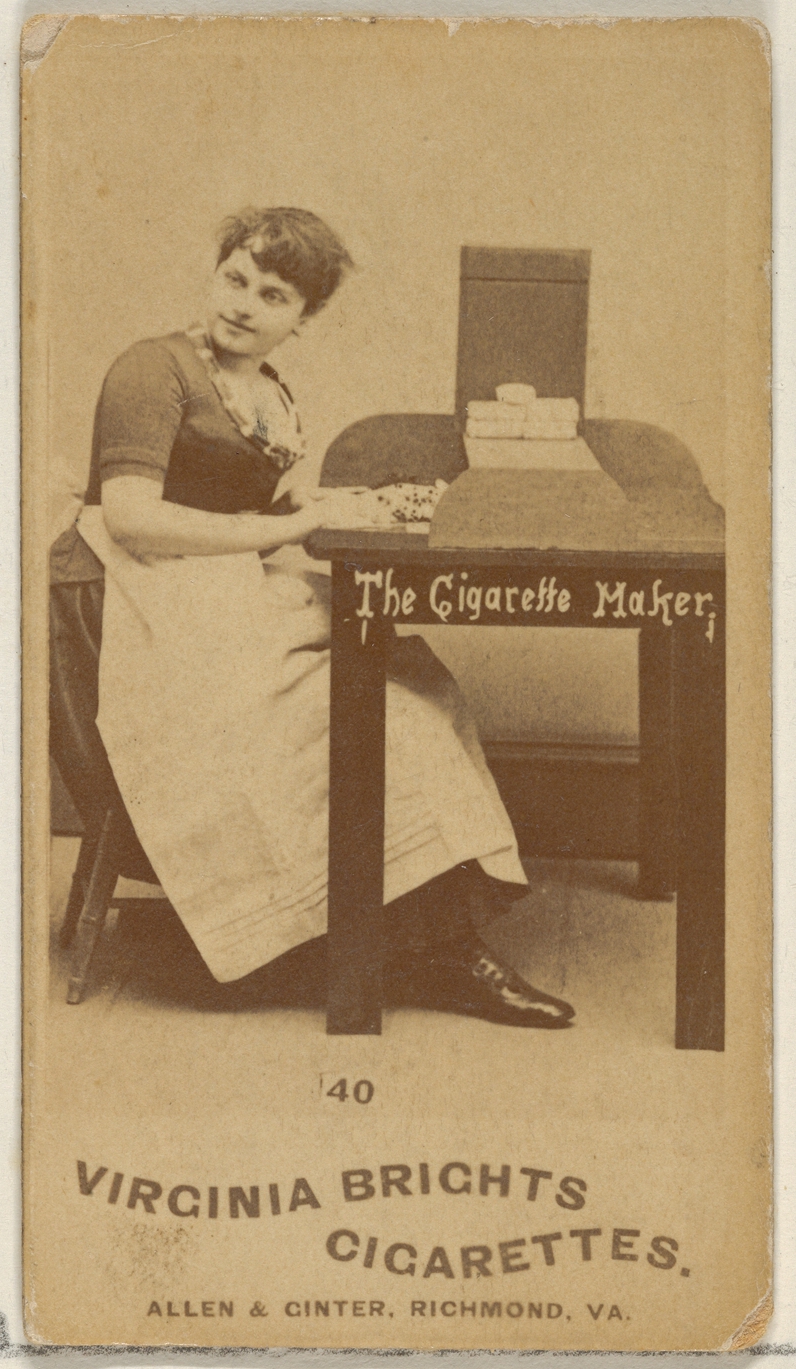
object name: photograph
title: Card 40, from the series, Cigarette Making Girls (N46) for Virginia Brights Cigarettes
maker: allen & ginter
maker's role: publisher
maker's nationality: american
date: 1888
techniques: albumen silver print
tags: portraits,women